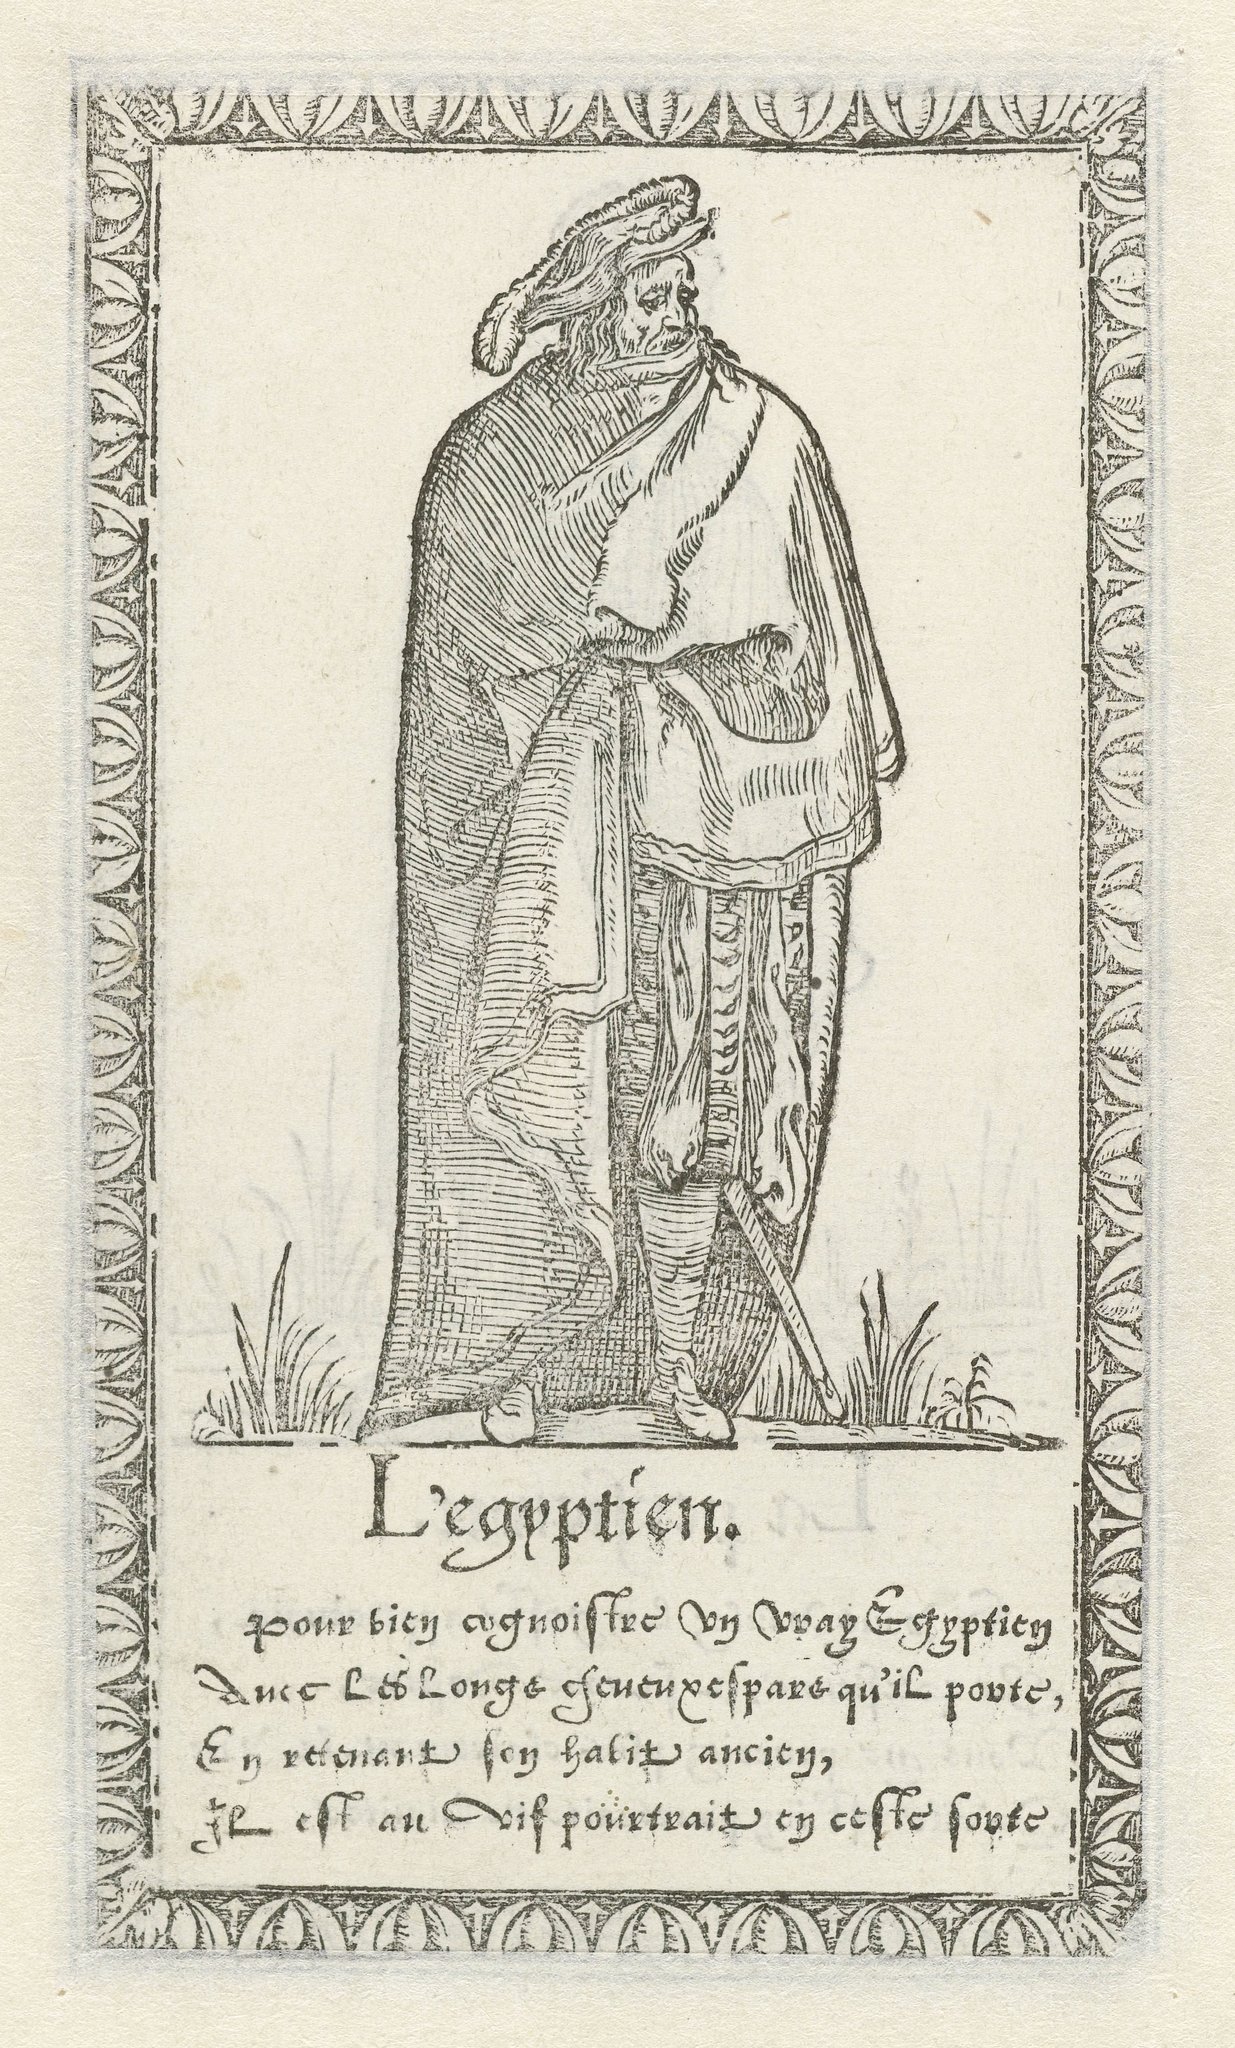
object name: print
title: Man uit Egypte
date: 1562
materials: paper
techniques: woodcut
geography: paris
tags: africans (+ costume), fashion plates, head-gear: hat, folk costume, regional costume, coat, cape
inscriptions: collector's mark: Lugt 2228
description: Dit is prent 97 uit een serie van 121. Binnen deze serie zijn er prenten gemaakt naar voorbeelden van Jean-François de Roberval en Enea Vico, onbekend welke precies.